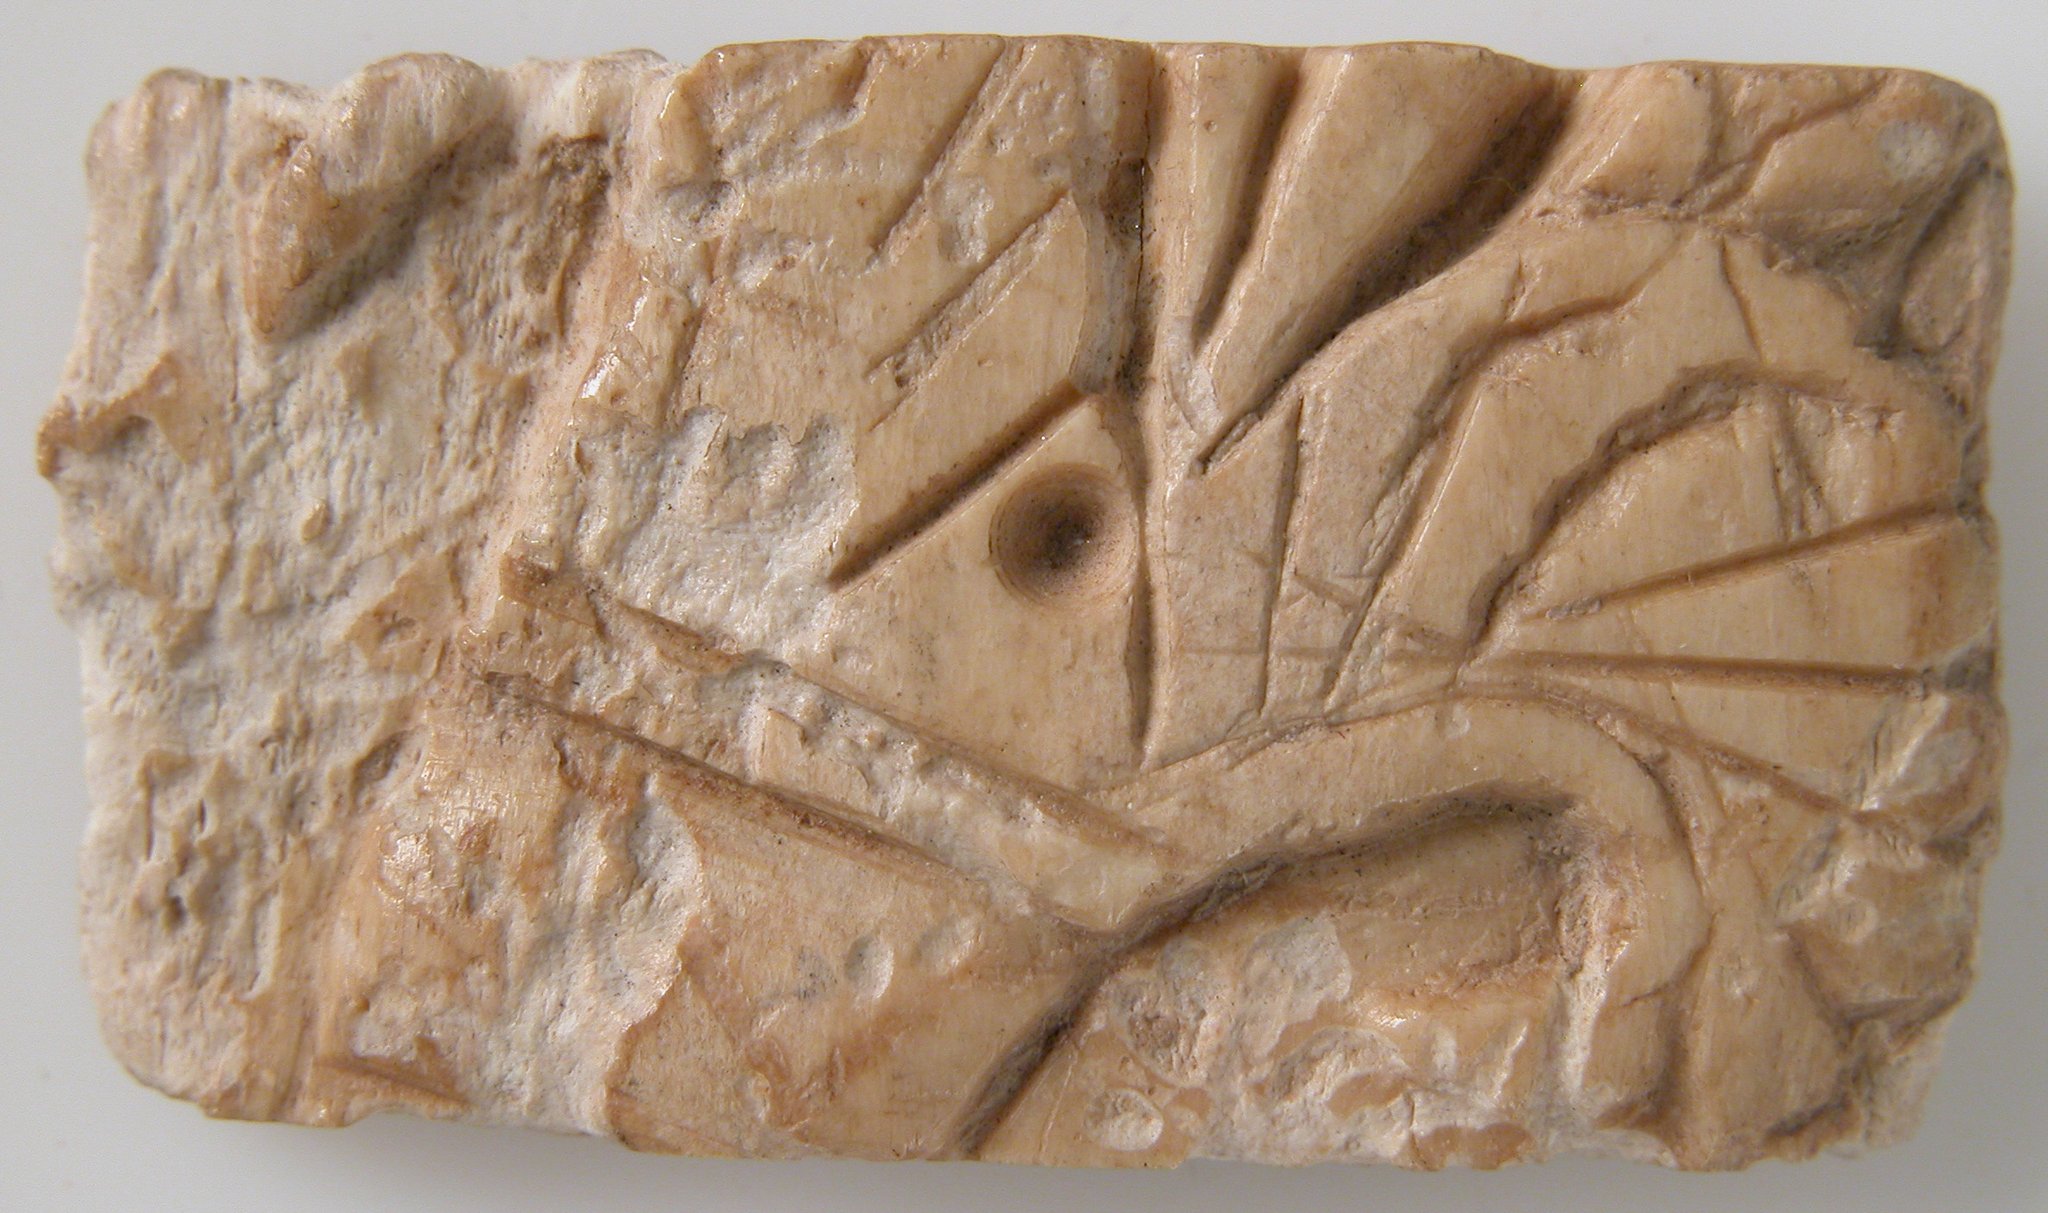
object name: fragment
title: Relief Fragment with Lotus Design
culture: coptic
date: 501-700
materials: ivory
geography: egypt